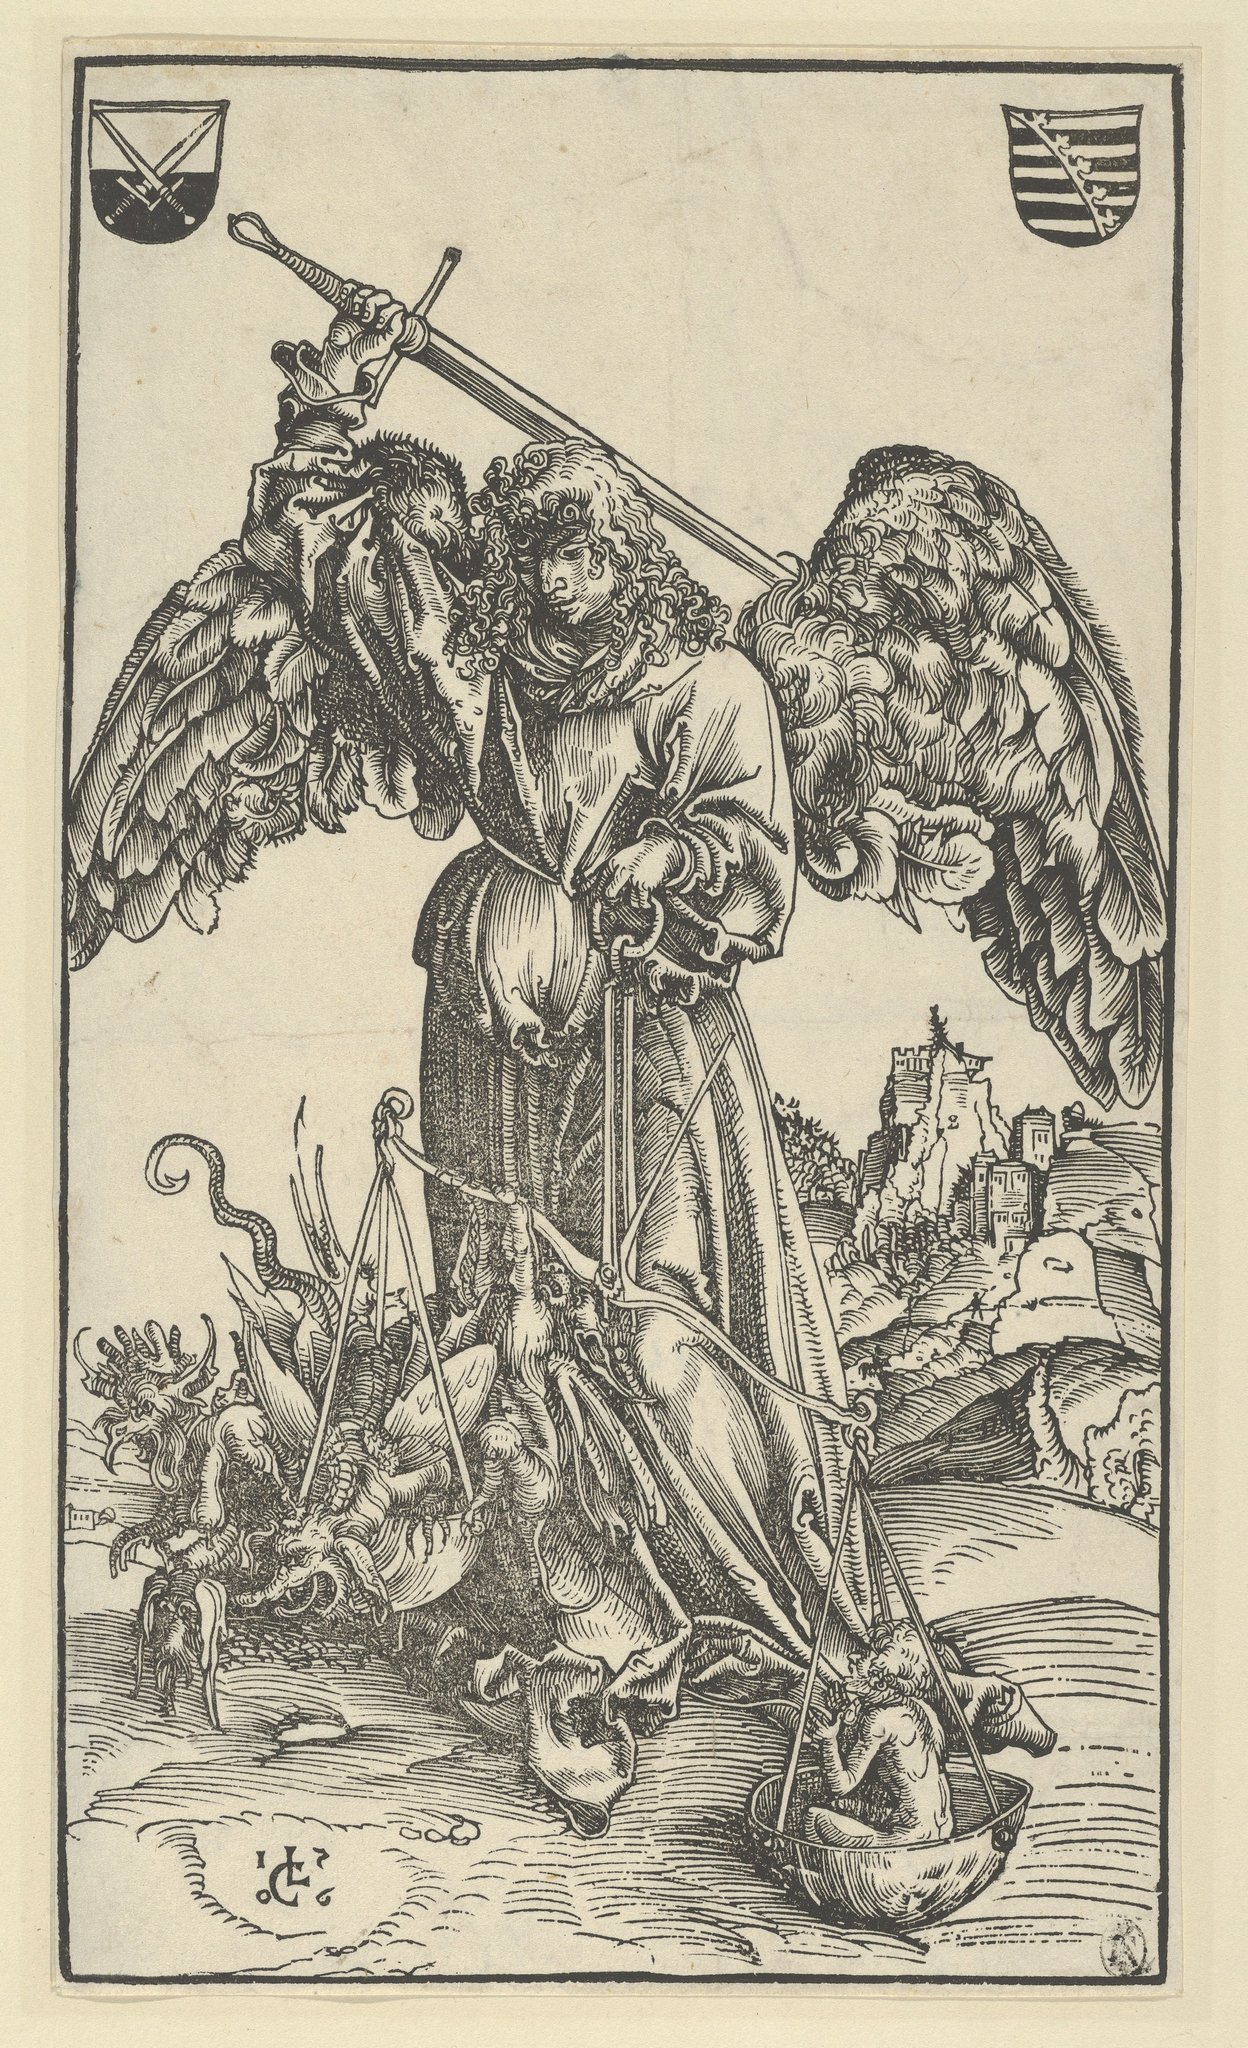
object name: print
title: The Archangel Michael Weighing a Soul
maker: lucas cranach the elder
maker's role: artist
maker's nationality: german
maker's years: 1472-1553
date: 1506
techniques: woodcut